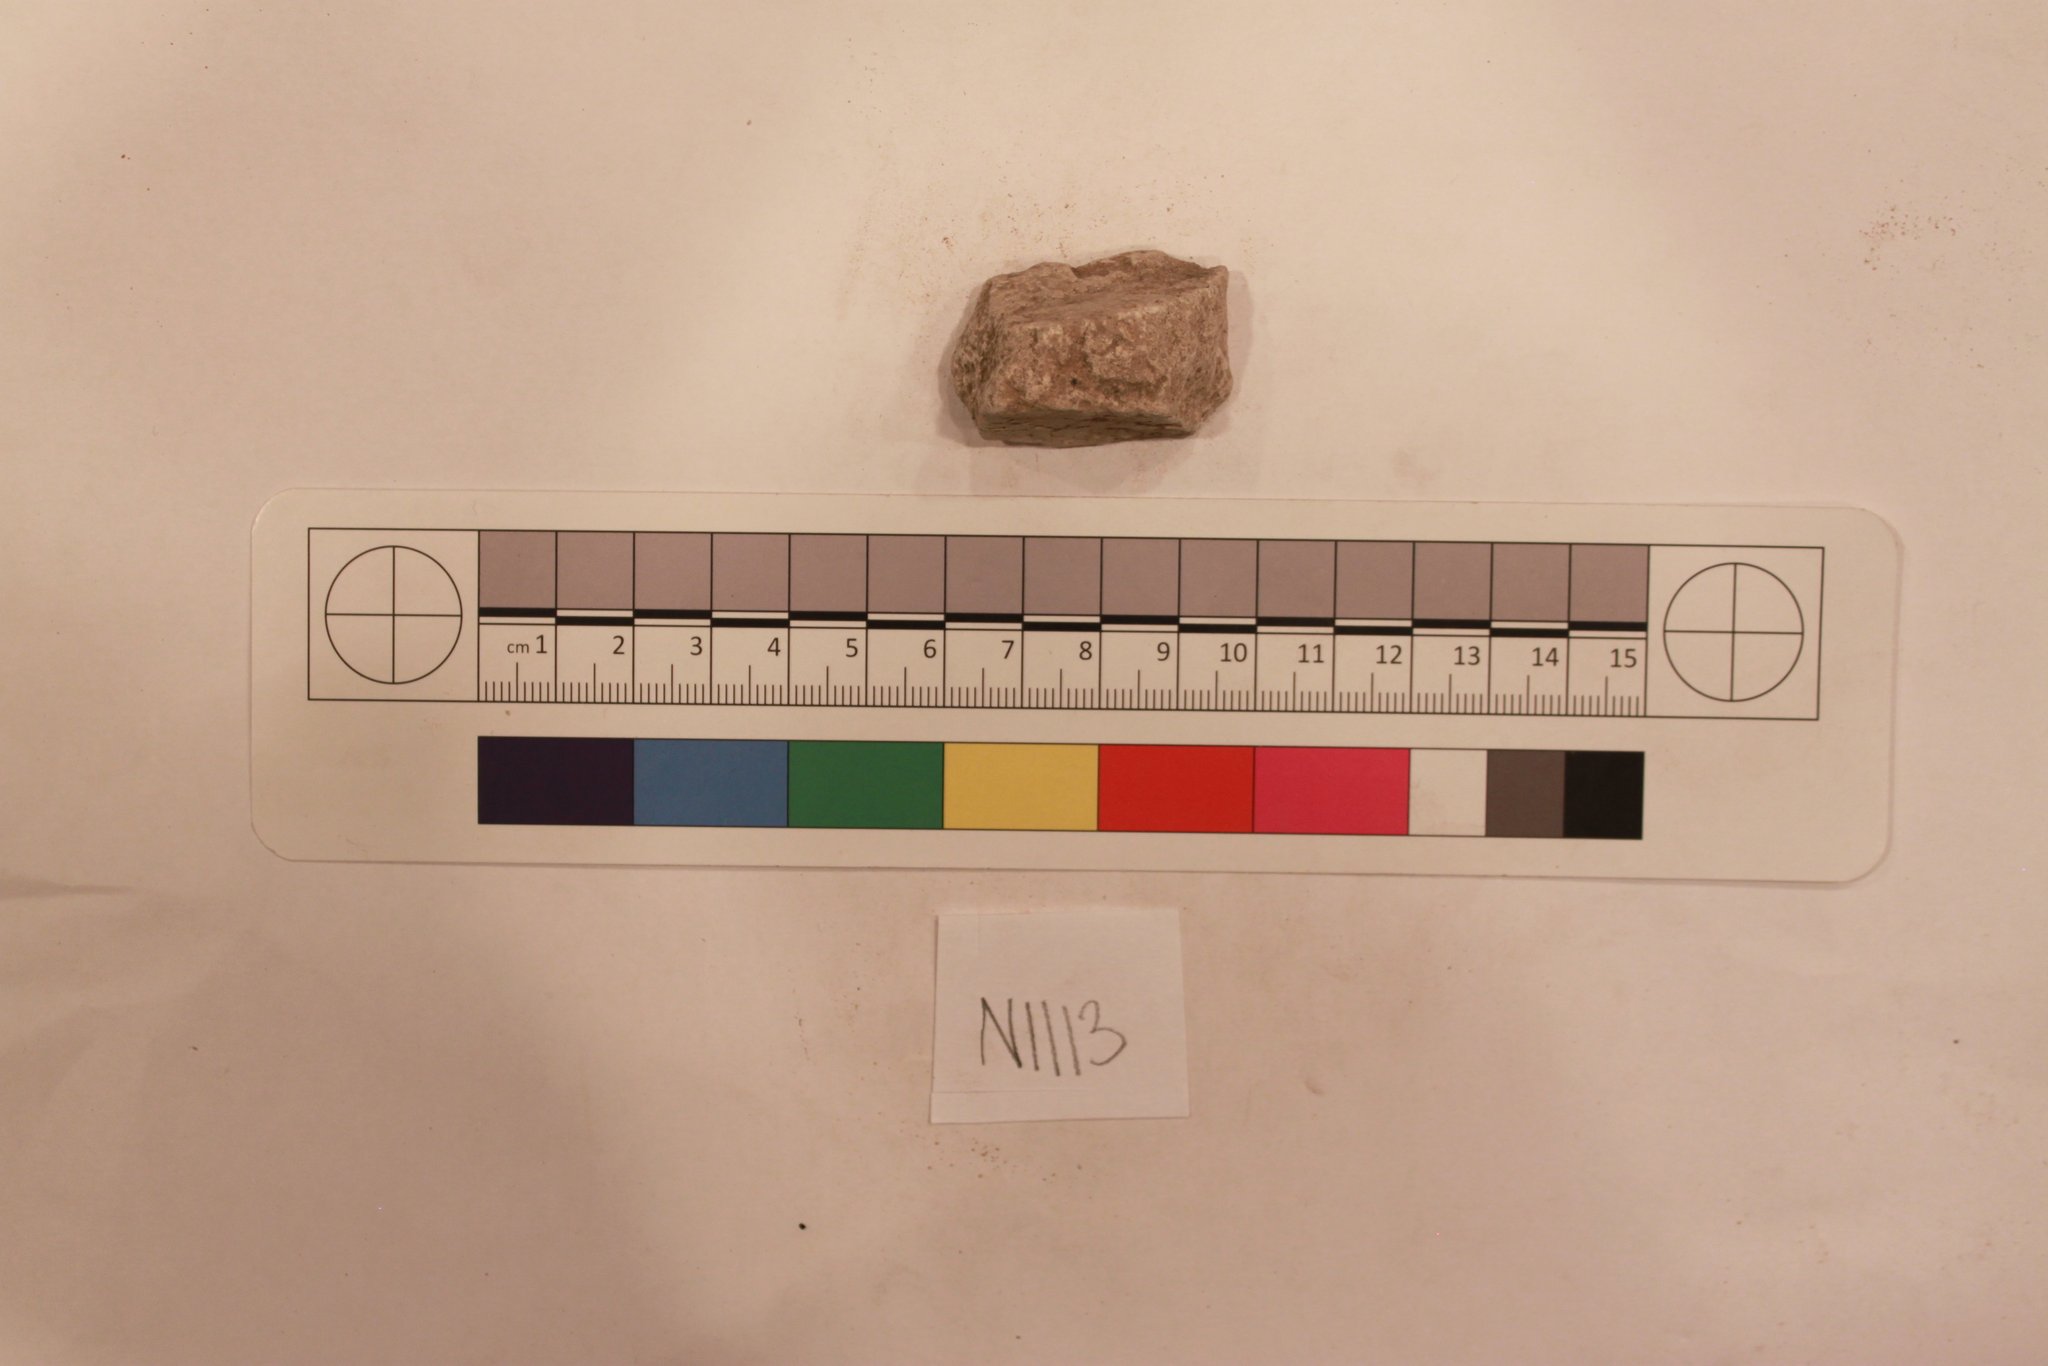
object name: fragment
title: Stucco Fragment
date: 701-1200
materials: plaster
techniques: carving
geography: iran